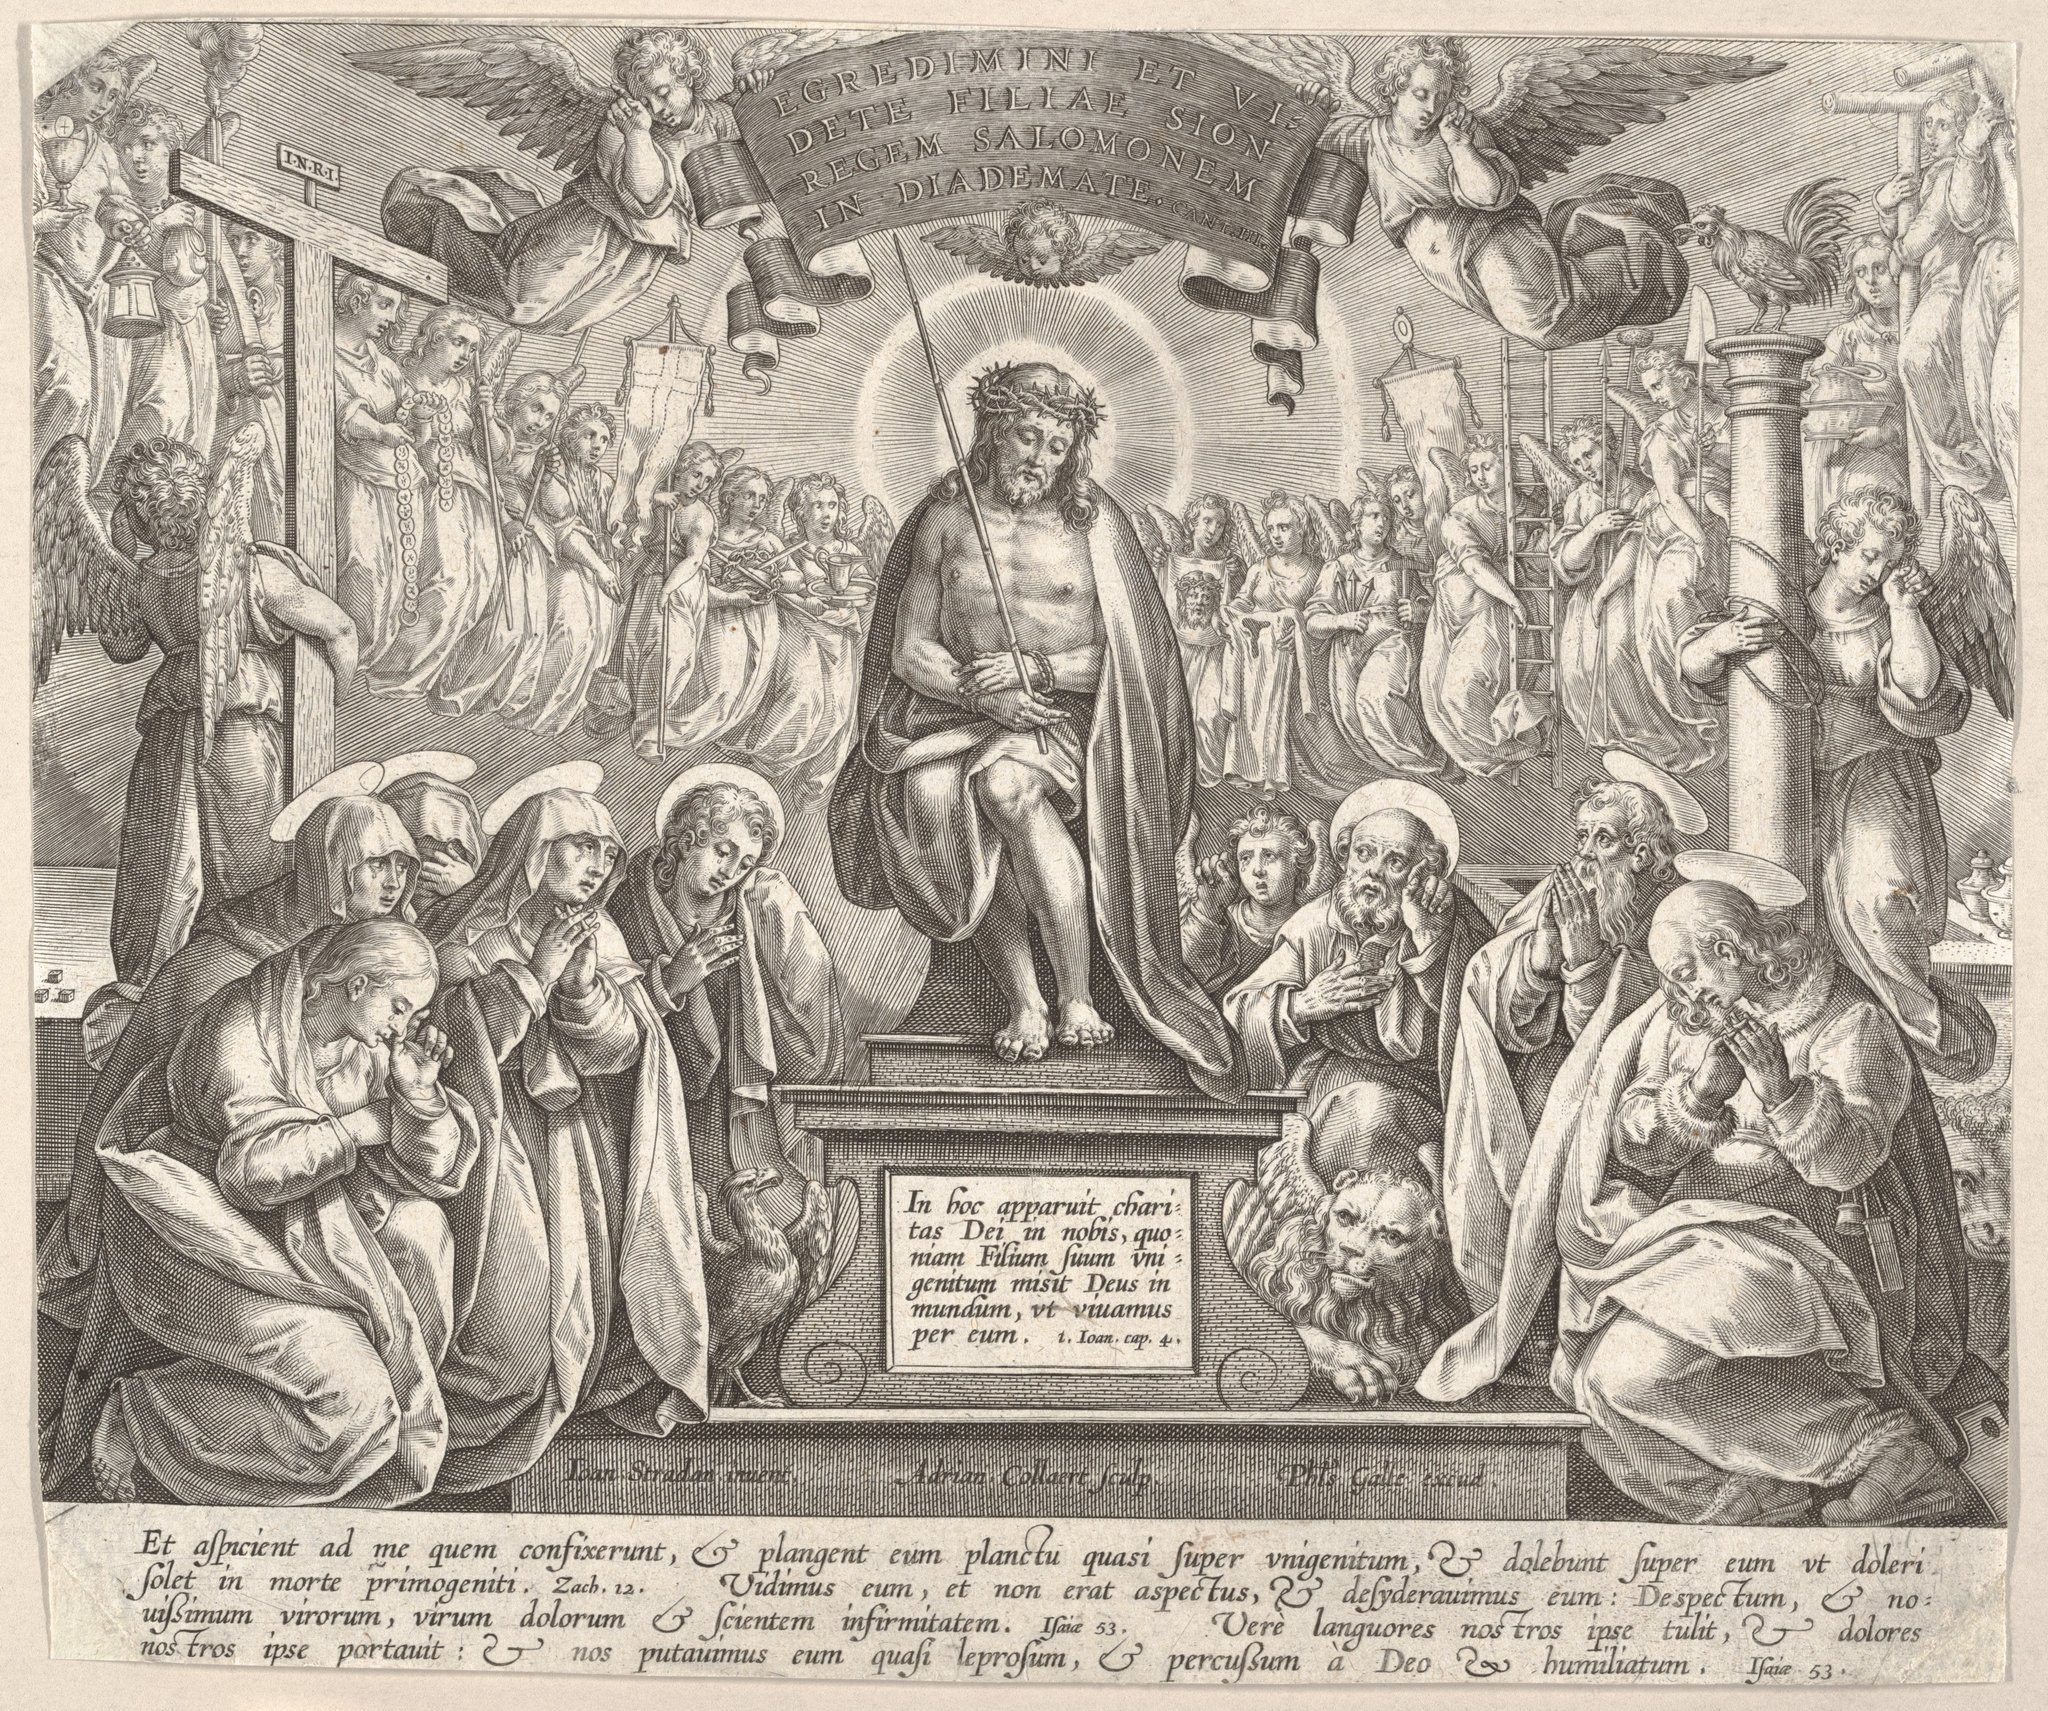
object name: print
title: Man of Sorrows with the Three Marys and the Evangelists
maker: adriaen collaert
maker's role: artist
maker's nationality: netherlandish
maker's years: 1560-1618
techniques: engraving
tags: men,women,angels,saint john the evangelist